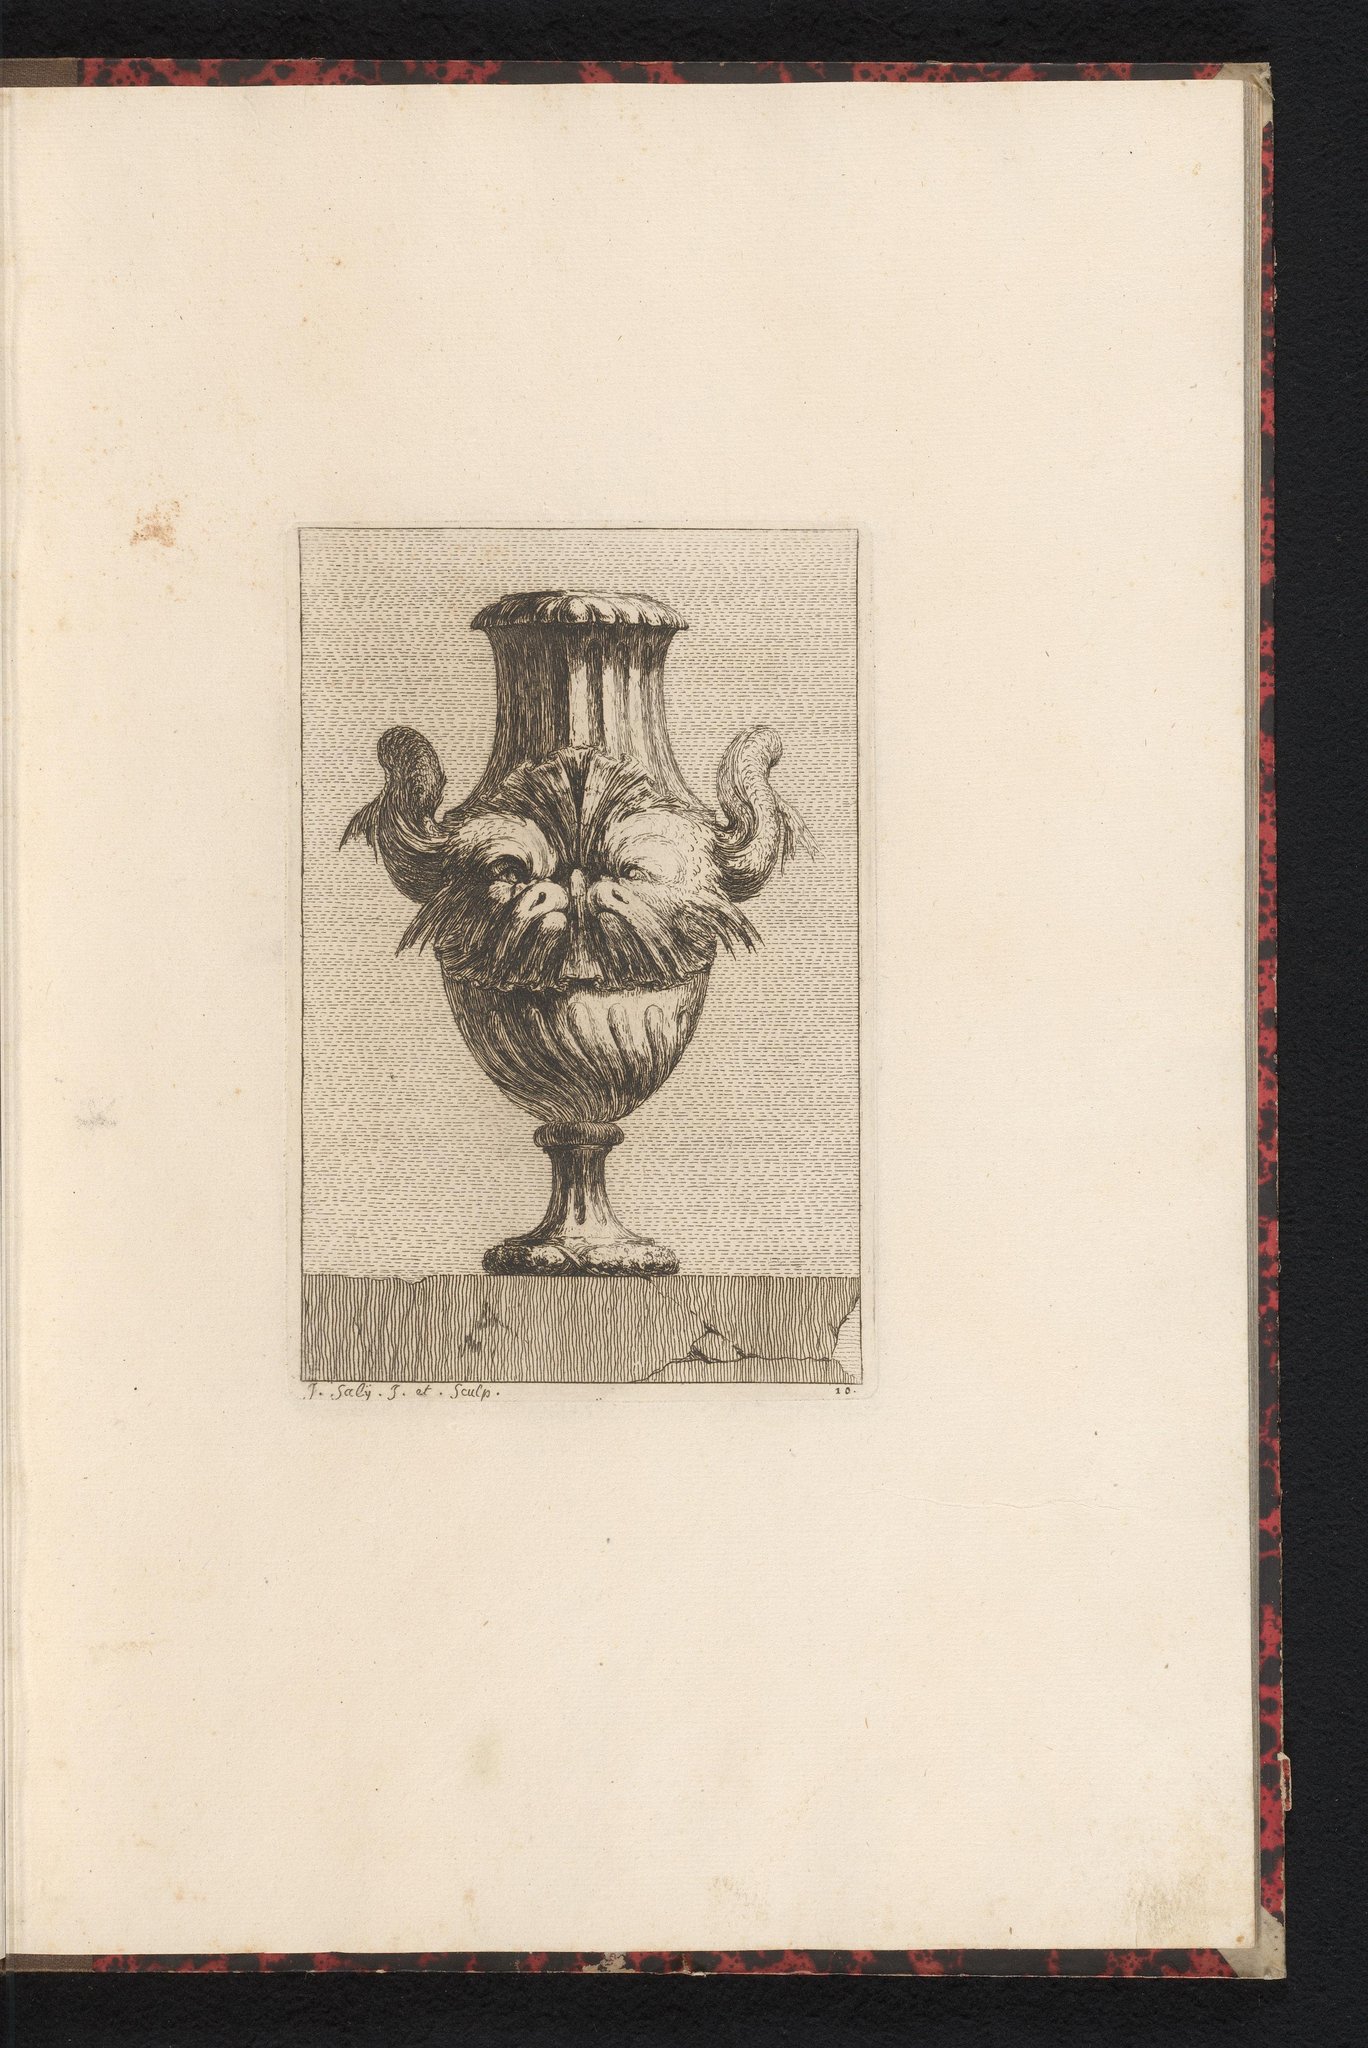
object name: album leaf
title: Ontwerpen voor vazen door Jacques Saly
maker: jacques francois joseph saly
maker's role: print maker, sculptor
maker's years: 1717-1776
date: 1746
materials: paper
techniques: etching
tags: dolphin ~ ornament, garden vase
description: Deze prent maakt deel uit van een album.